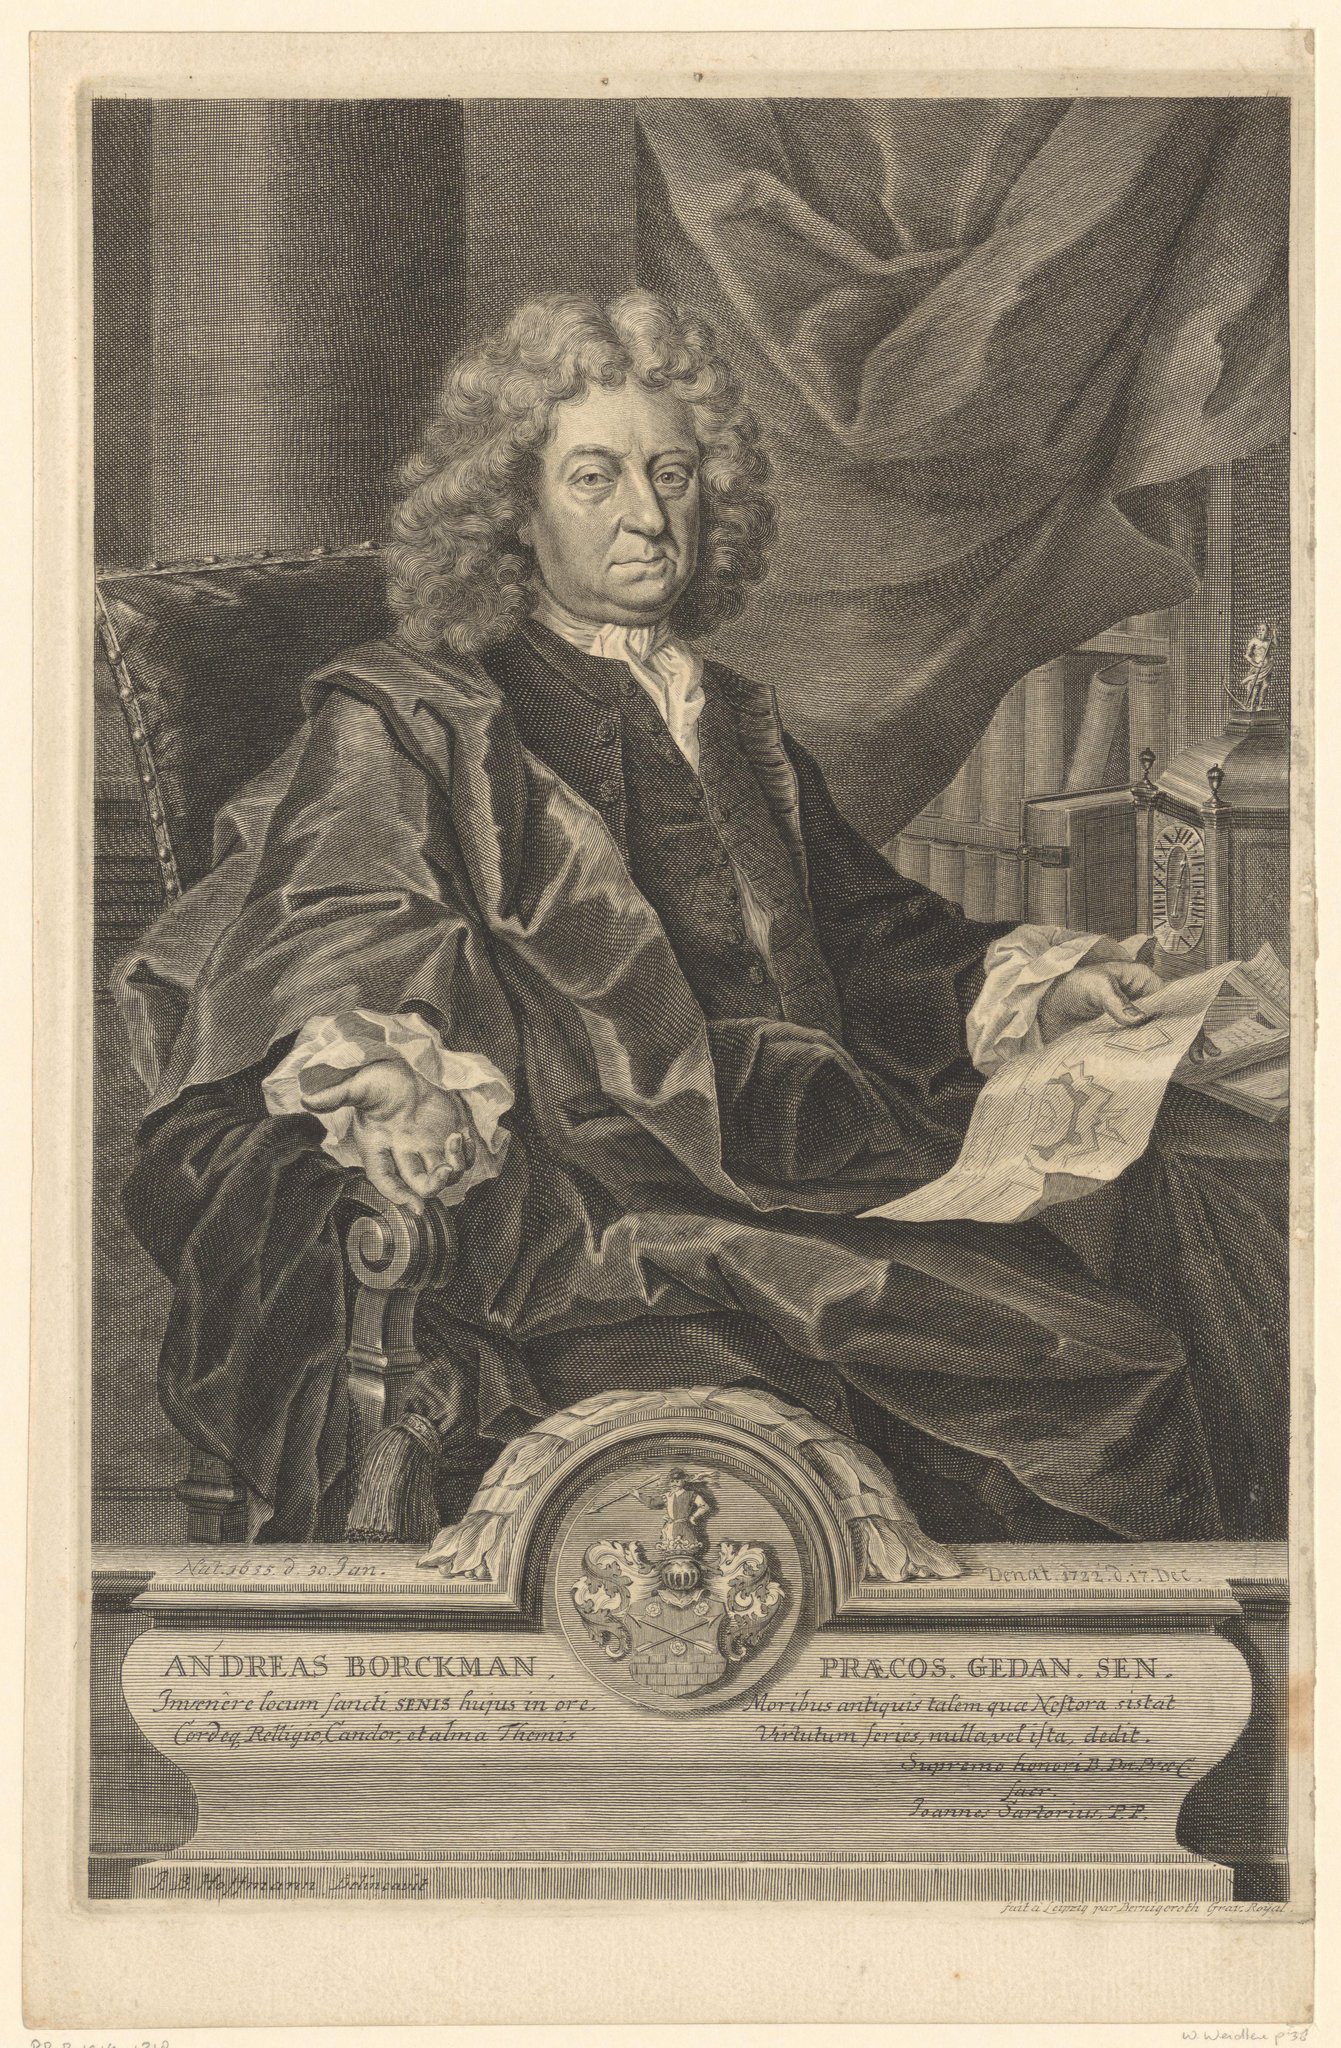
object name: print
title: Portret van Andreas Borckman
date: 1722-1733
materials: paper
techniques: engraving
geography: danzig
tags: mayor, bookshelves, historical persons, clock, fortifications, military engineering, armorial bearing, heraldry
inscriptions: collector's mark: Lugt 2228